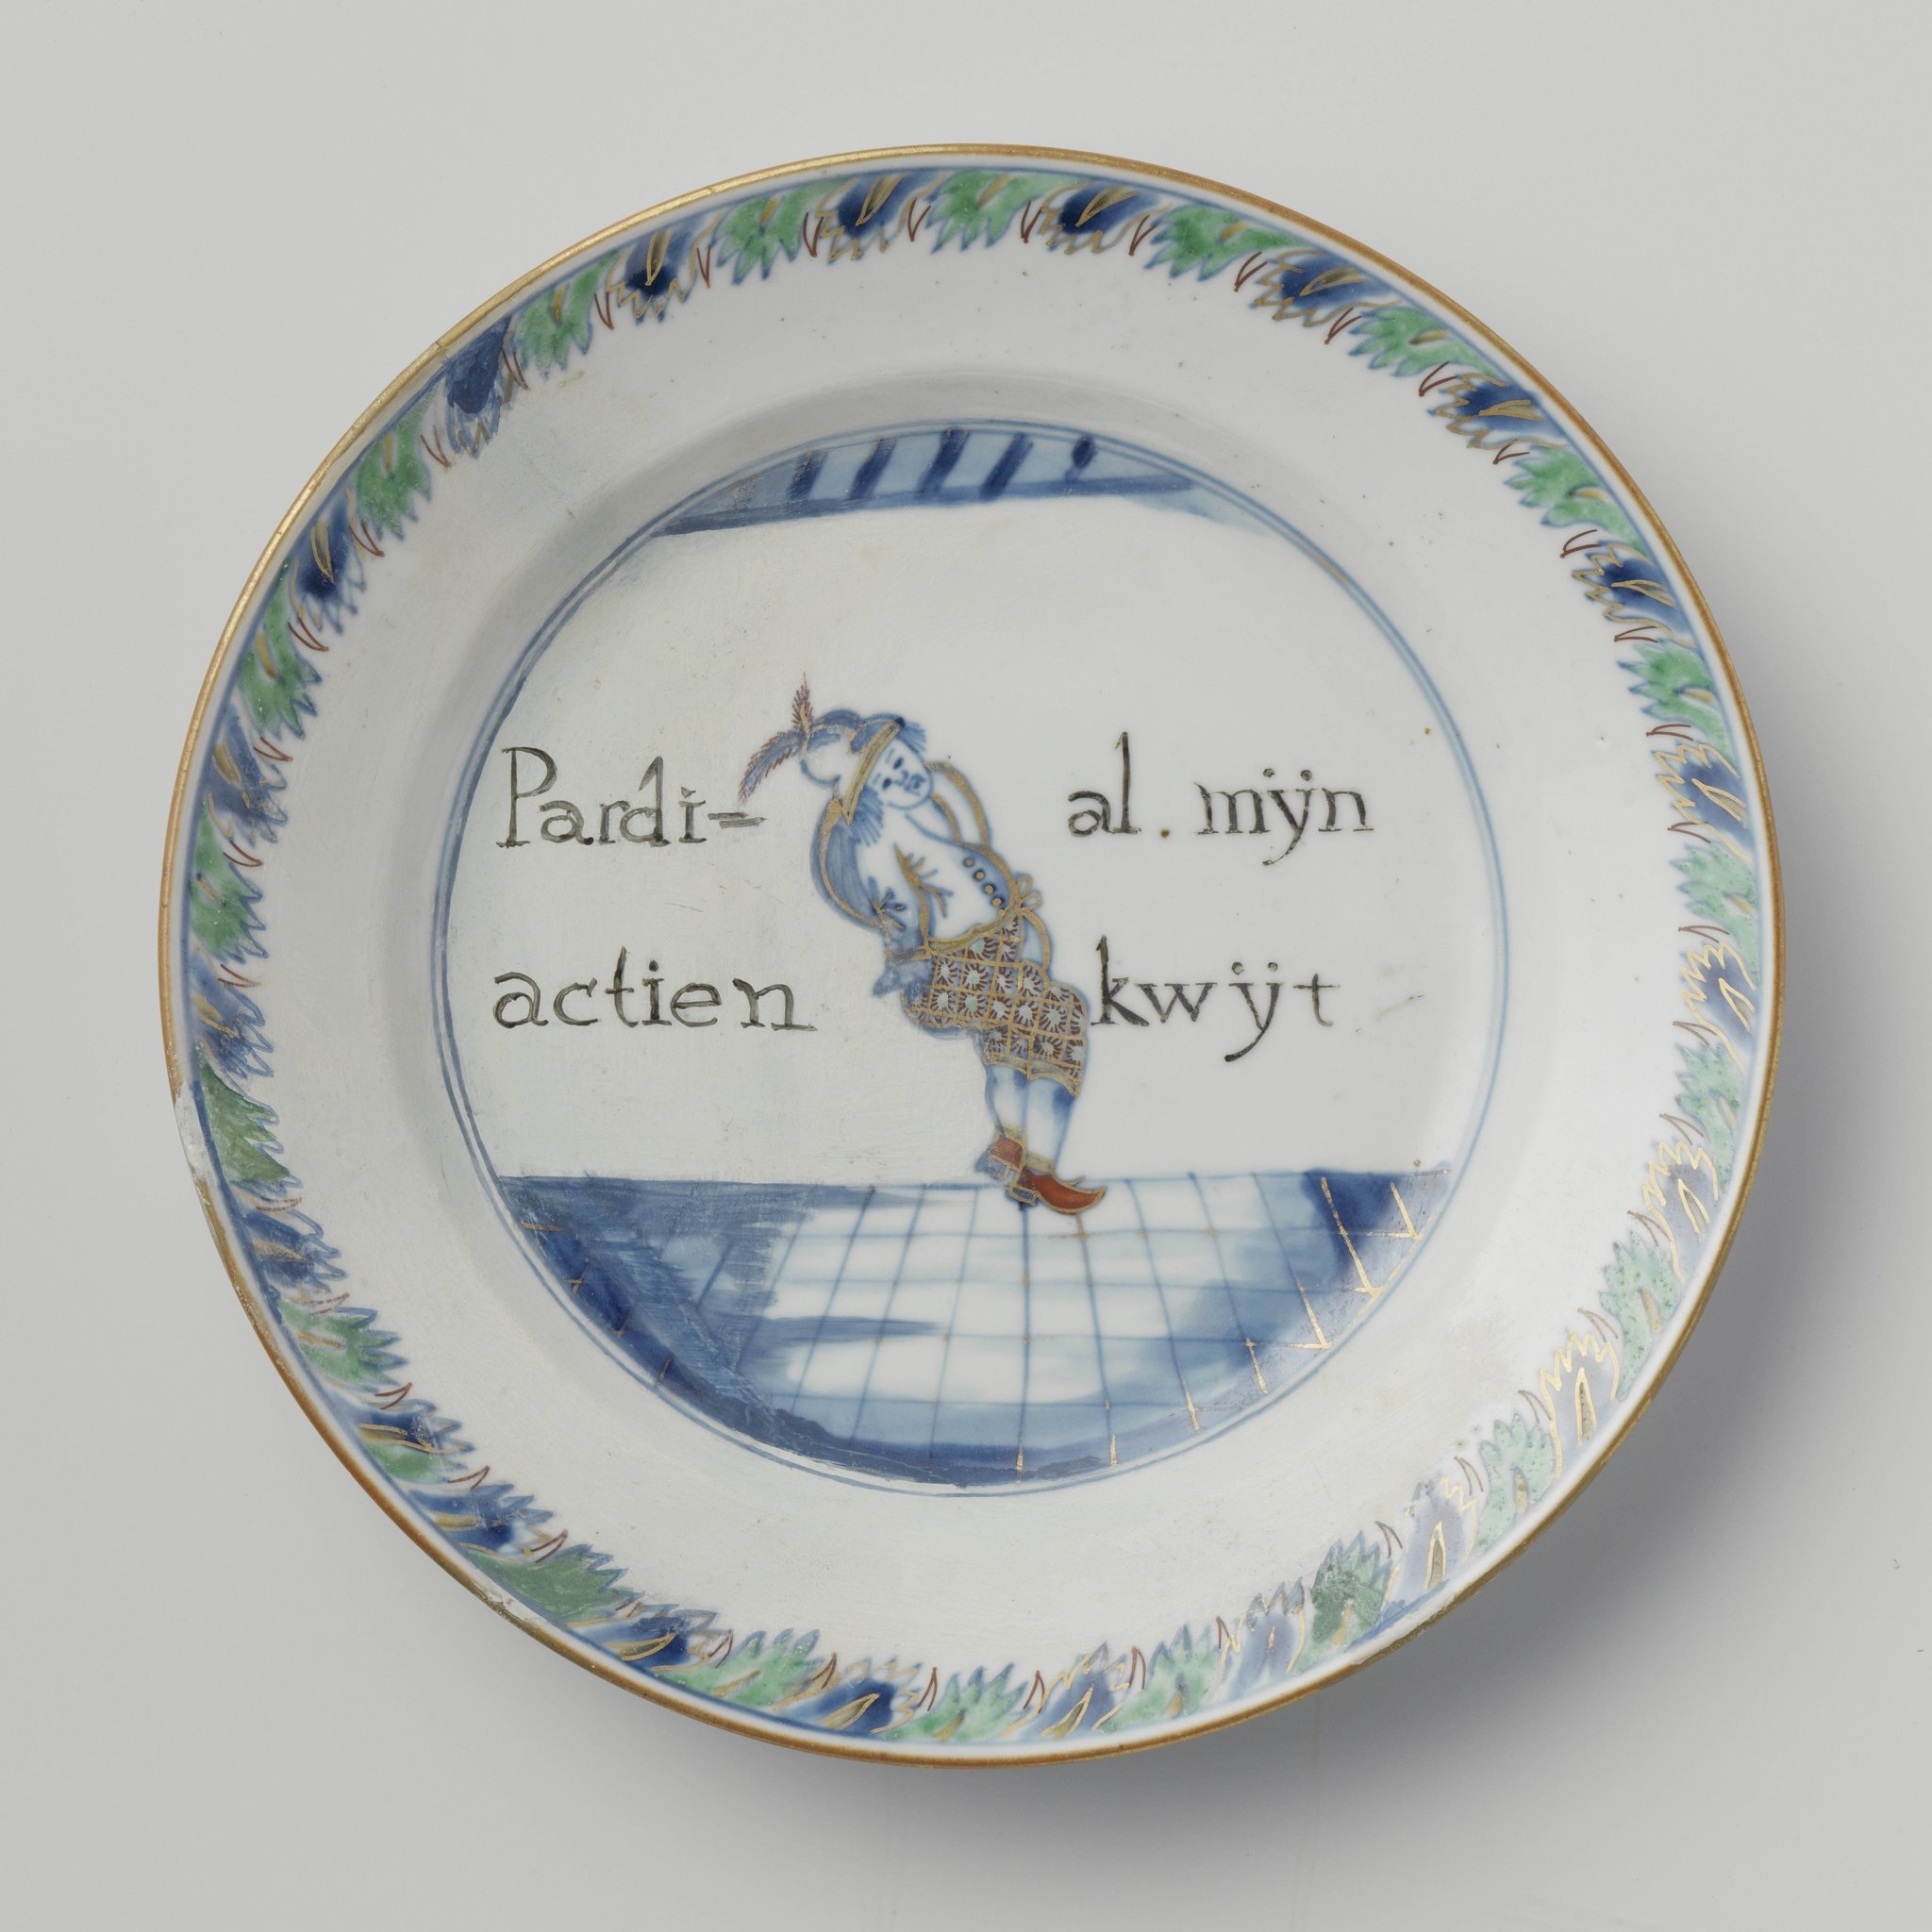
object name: plate dish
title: Plate with a caricatural figure and inscription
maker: Anonymous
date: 1725-1749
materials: cobalt, glaze, gold, paint, porcelain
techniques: firing, gilding, turning, vitrification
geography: china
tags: clown, types in 'commedia dell'arte': harlequin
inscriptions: inscription: ‘Pardi- al mijn actien kwijt’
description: Bord van porselein, beschilderd in onderglazuur blauw en op het glazuur groen, zwart en goud. Op het plat een harlekijn en de tekst: 'Pardi- al mijn actien kwijt'; de rand met een decoratief patroon. Actiebord. Europese voorstelling in blauw-wit met emailkleuren.